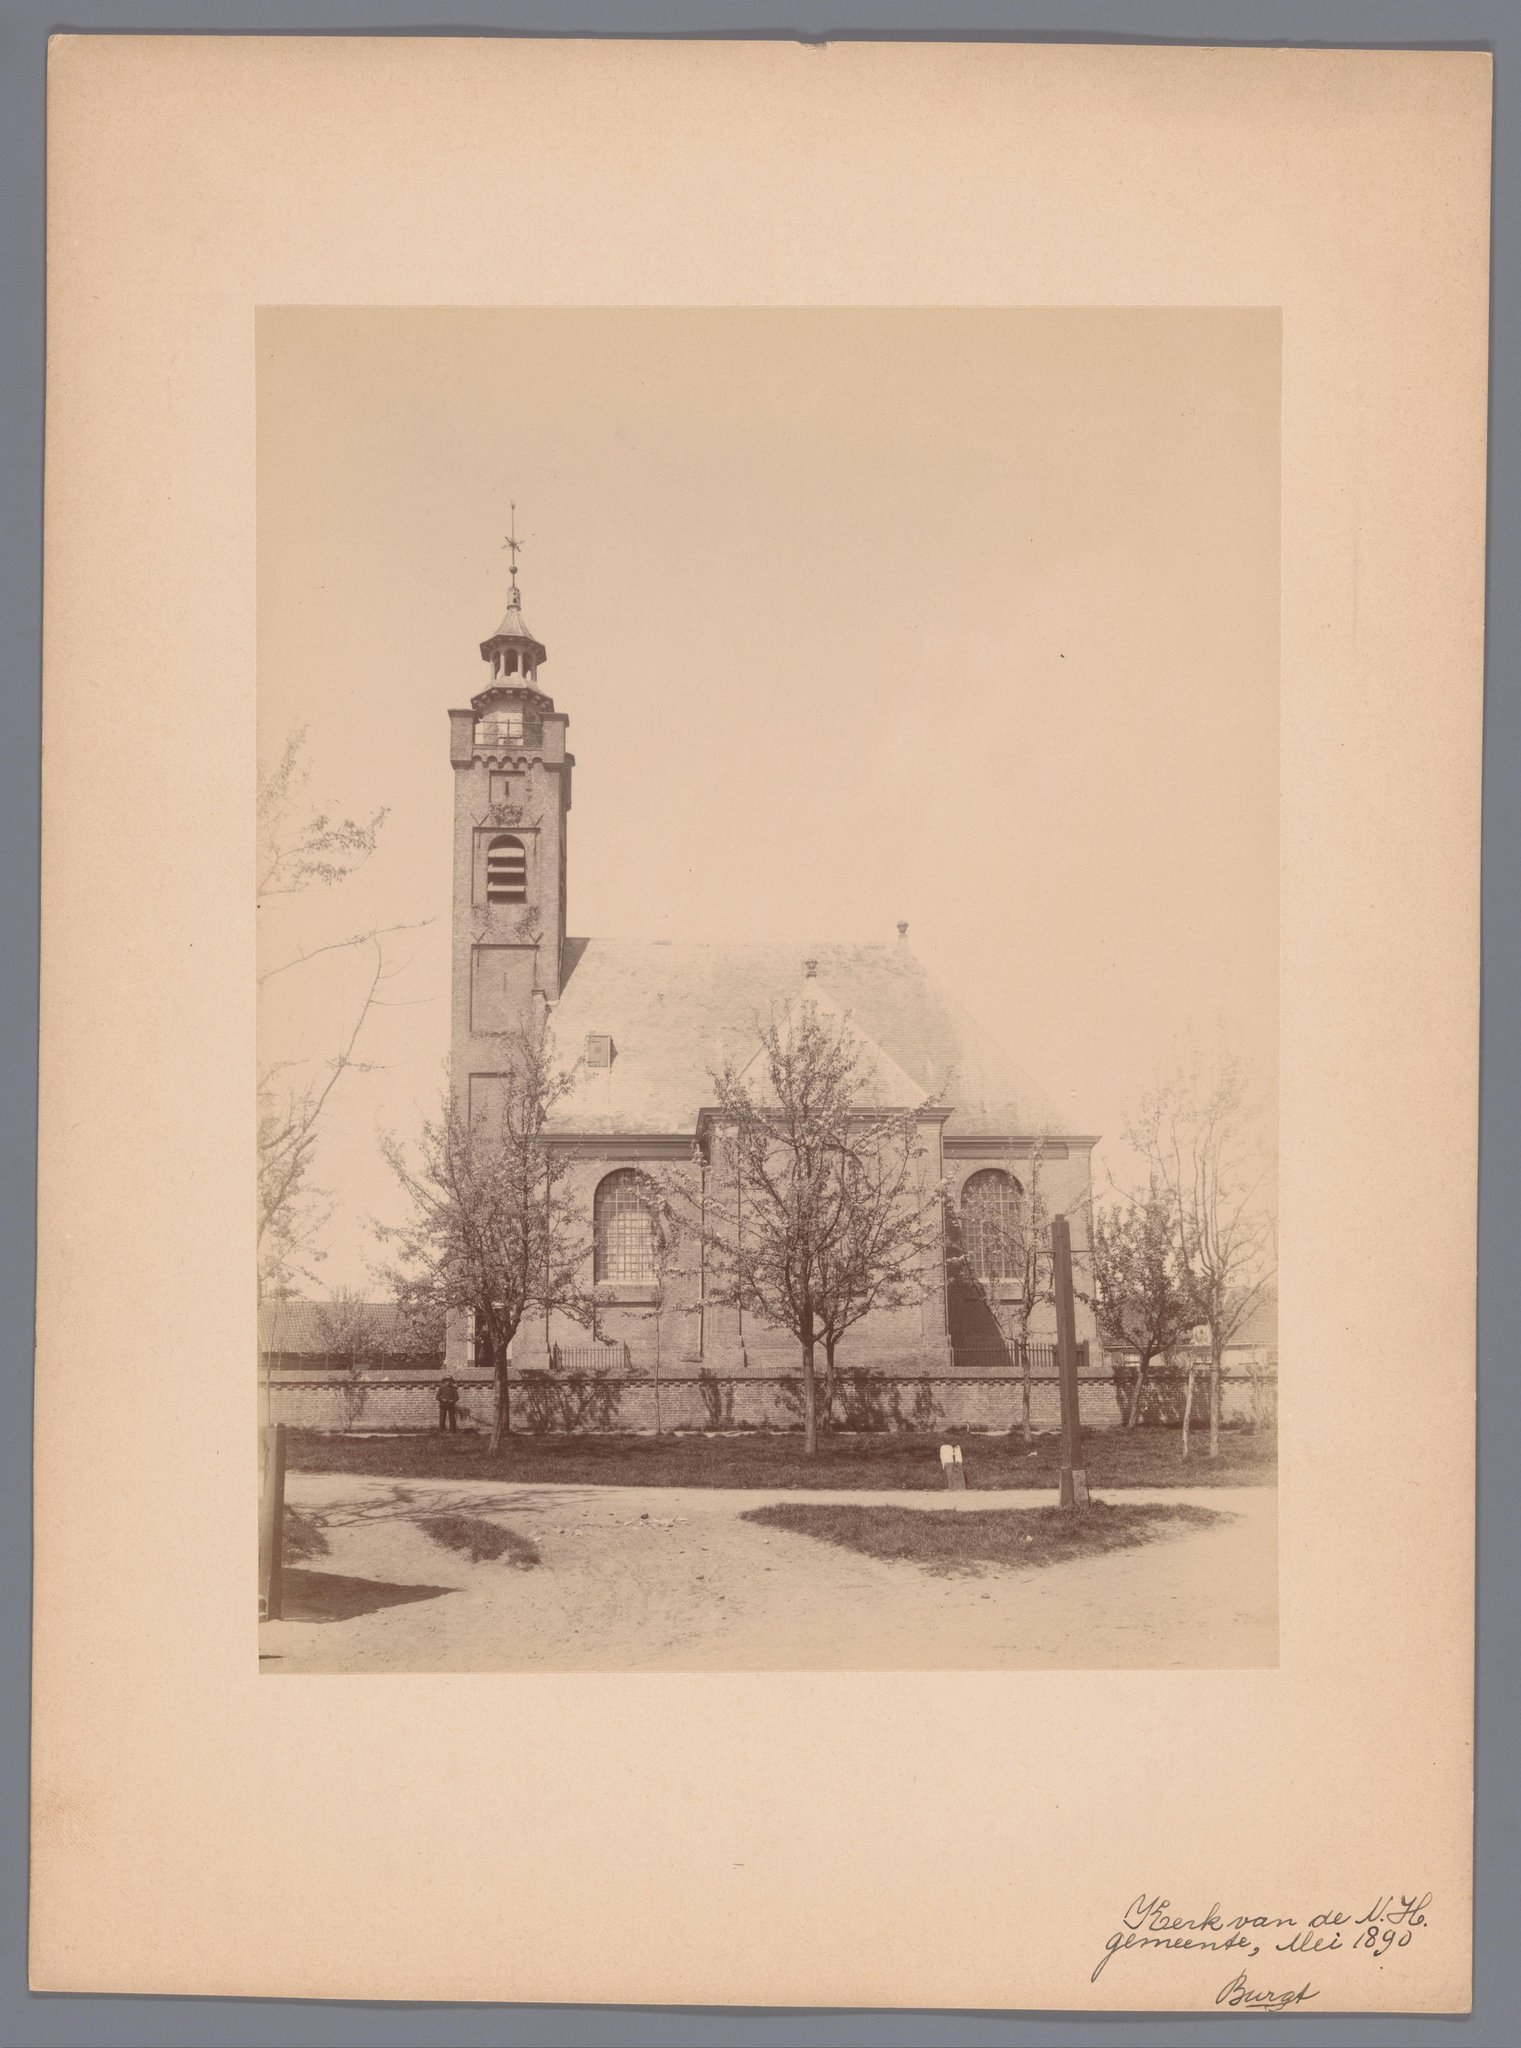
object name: photograph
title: Gezicht op de Hervormde Kerk te Burgh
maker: anoniem (monumentenzorg)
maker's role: fotograaf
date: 1890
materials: cardboard, photographic support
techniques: albumen print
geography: burgh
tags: church (exterior)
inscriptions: annotation: ‘Kerk v/d N.H. gemeente te Burgt (schouwen) Zeeland/ Mei 1890’, annotation: ‘Kerk van de N.H. gemeente, Mei 1890/ Burgt’